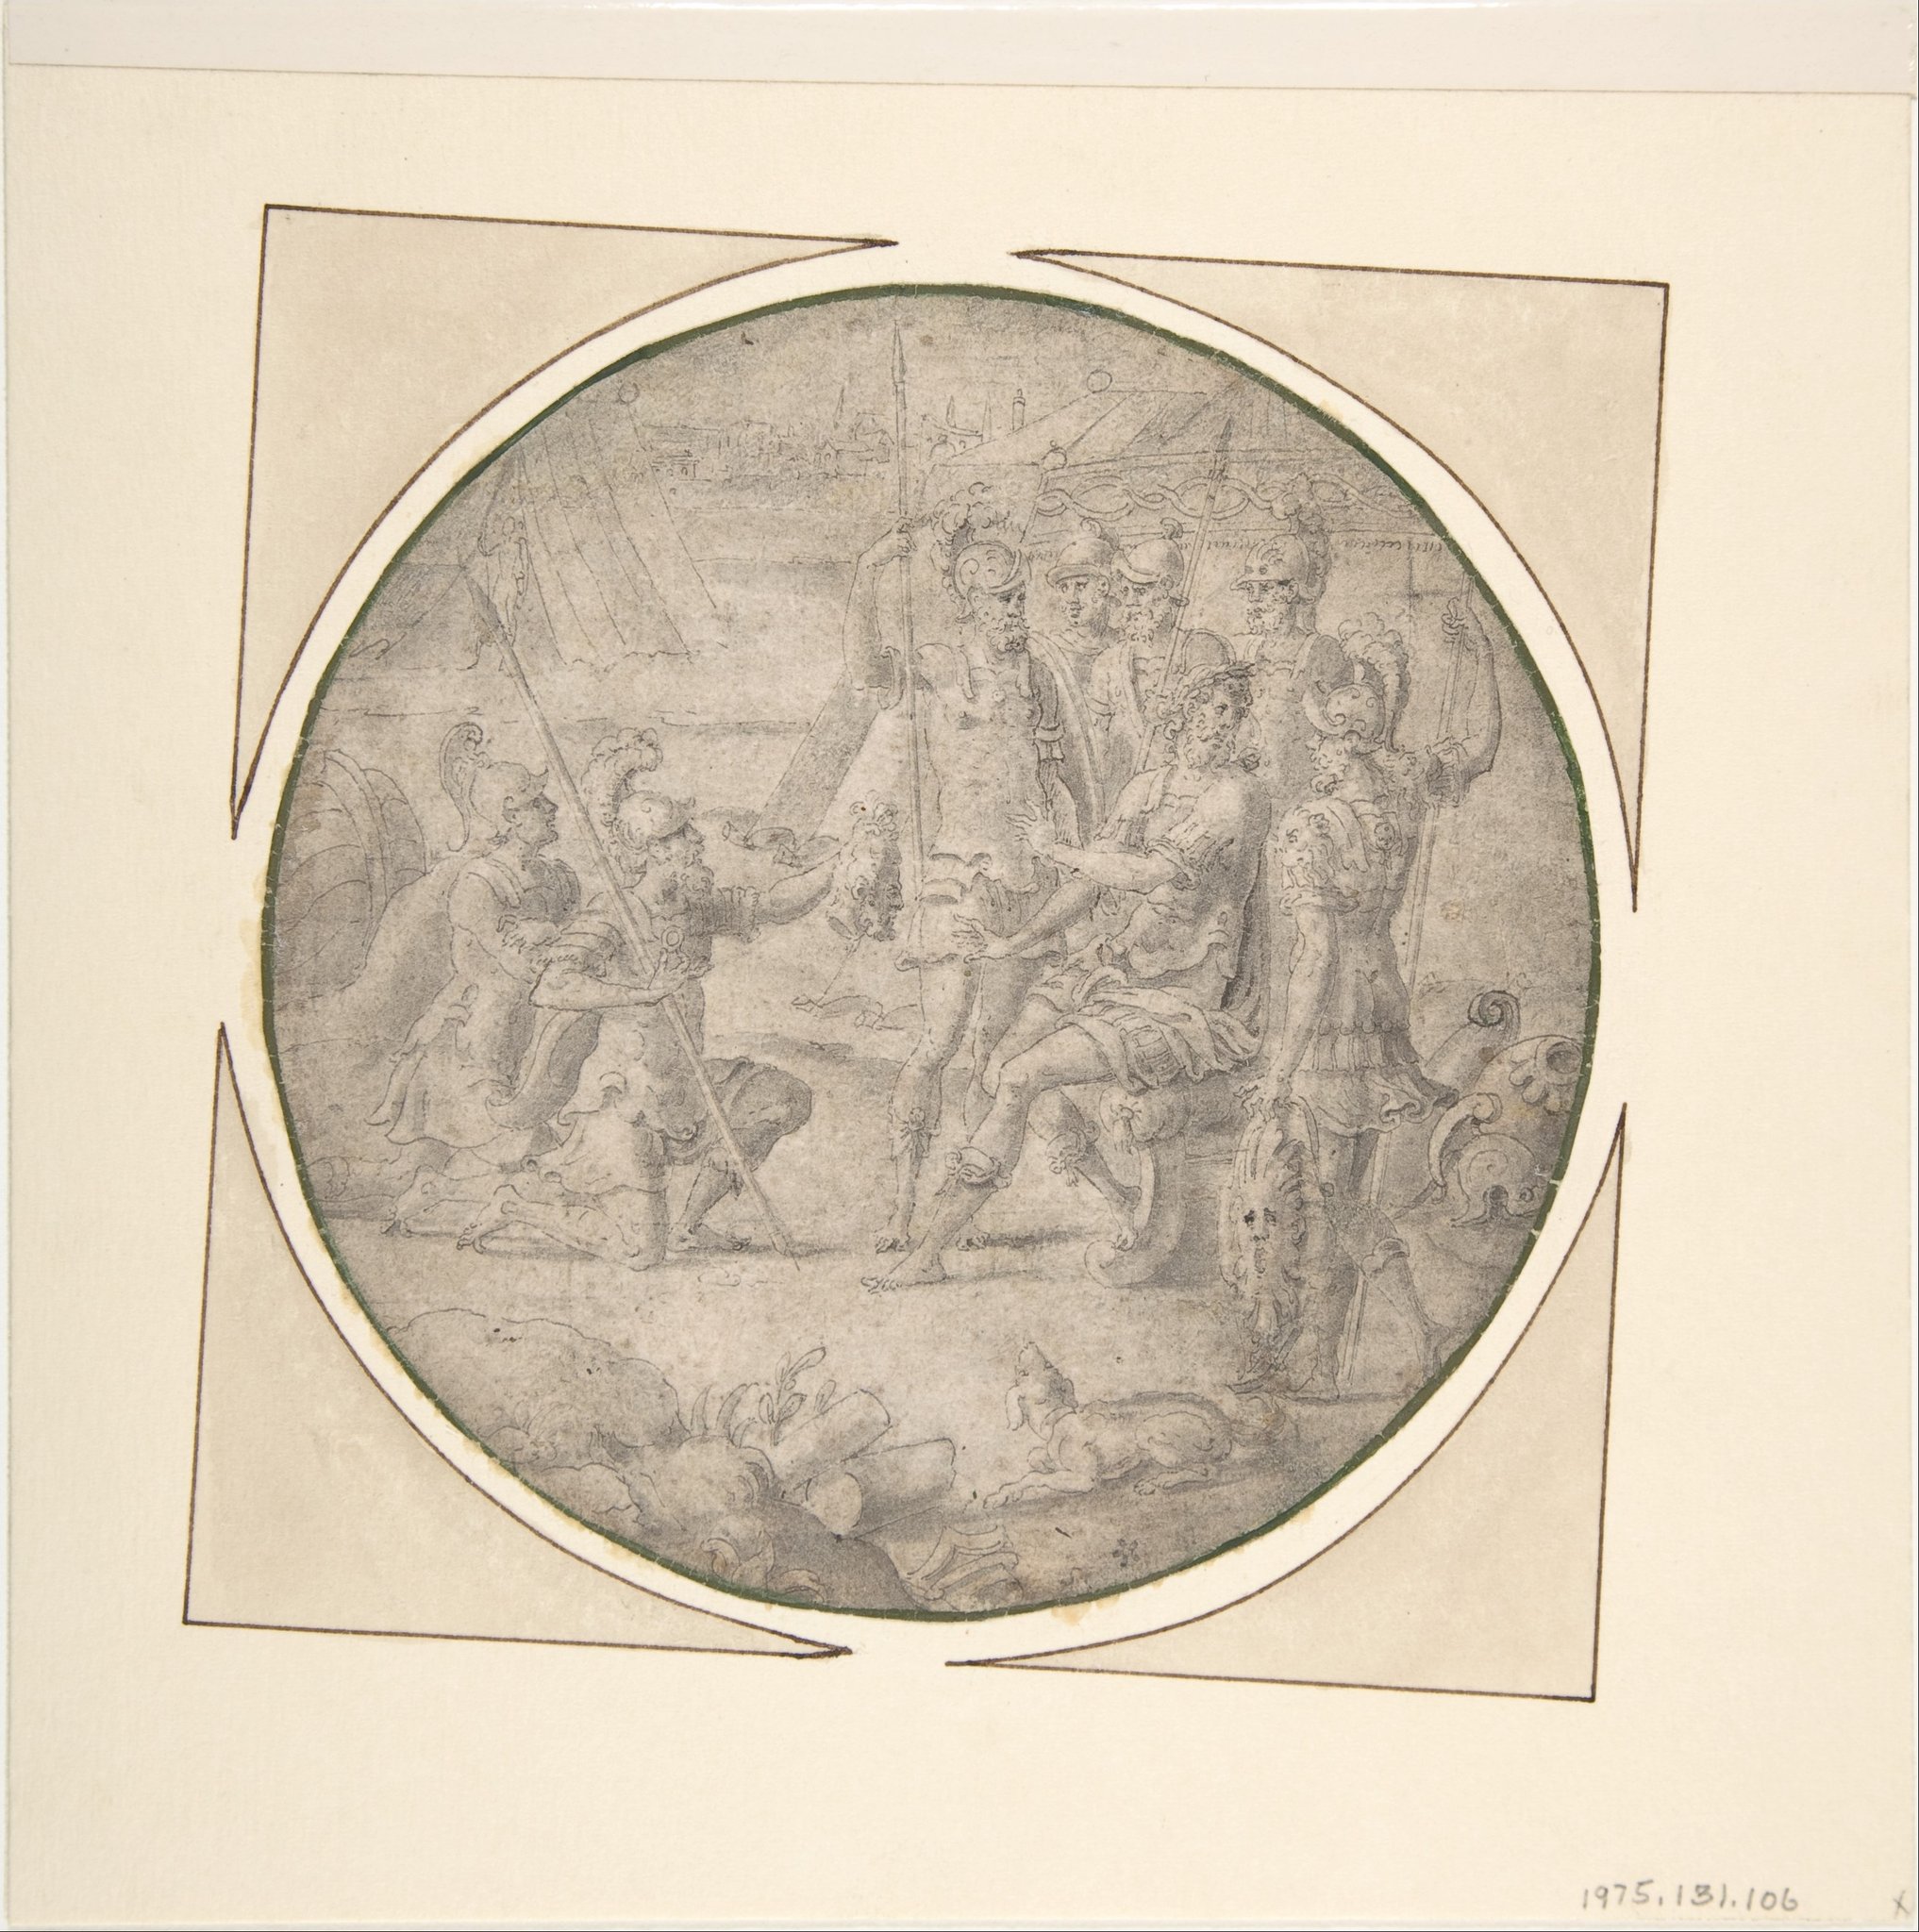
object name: drawing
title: The Head of Pompey Presented to Caesar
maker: anonymous, french, 16th century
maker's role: artist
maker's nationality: french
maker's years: 1500-1600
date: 1550-1600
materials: ink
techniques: brush, pen, wash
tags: soldiers,julius caesar,heads,men,dogs